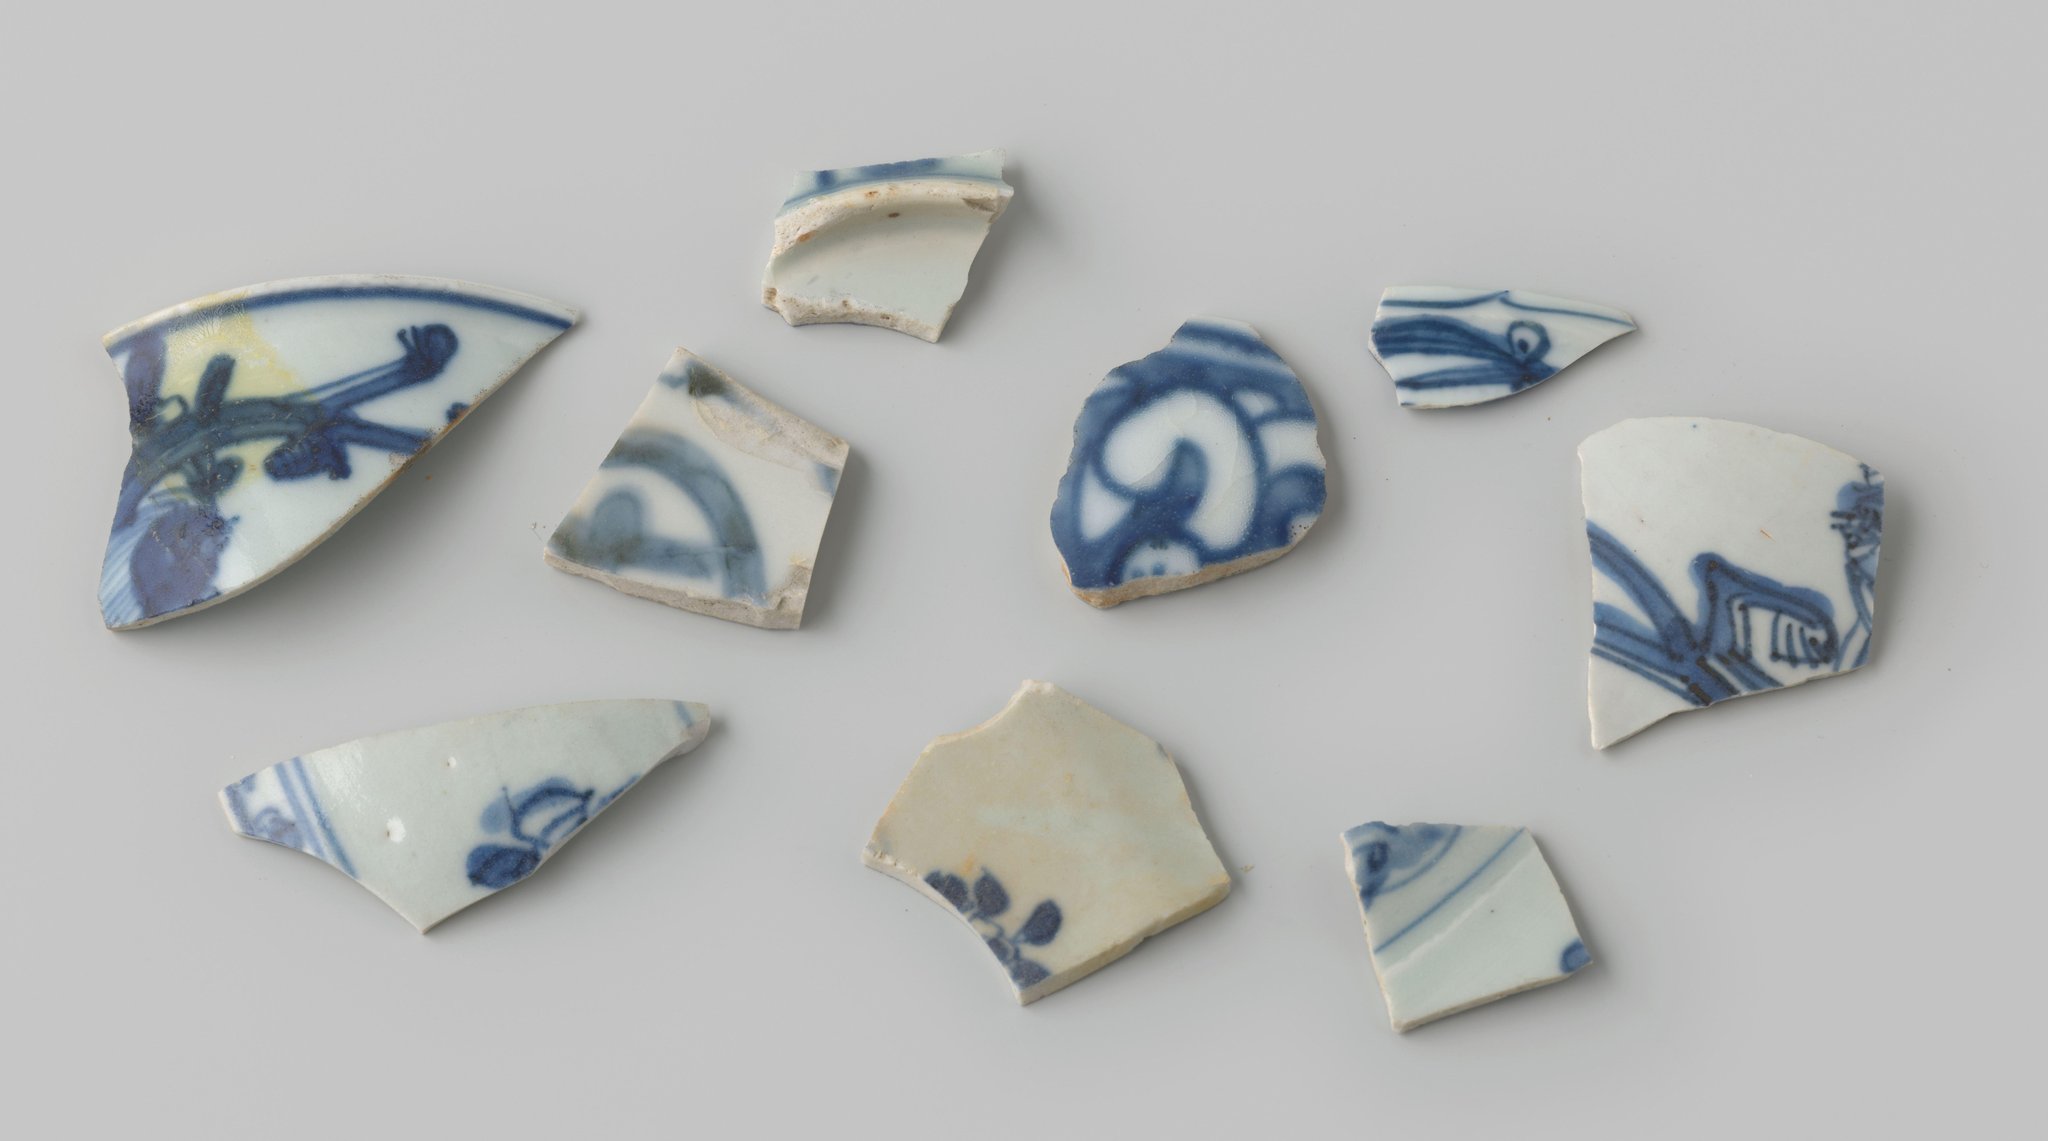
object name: sherd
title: Scherven van kommen uit V.O.C.-schip de 'Witte Leeuw'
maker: Anonymous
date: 1613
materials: porcelain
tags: verenigde oostindische compagnie, sint-helena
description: Scherven van kommen uit V.O.C.-schip de 'Witte Leeuw'.